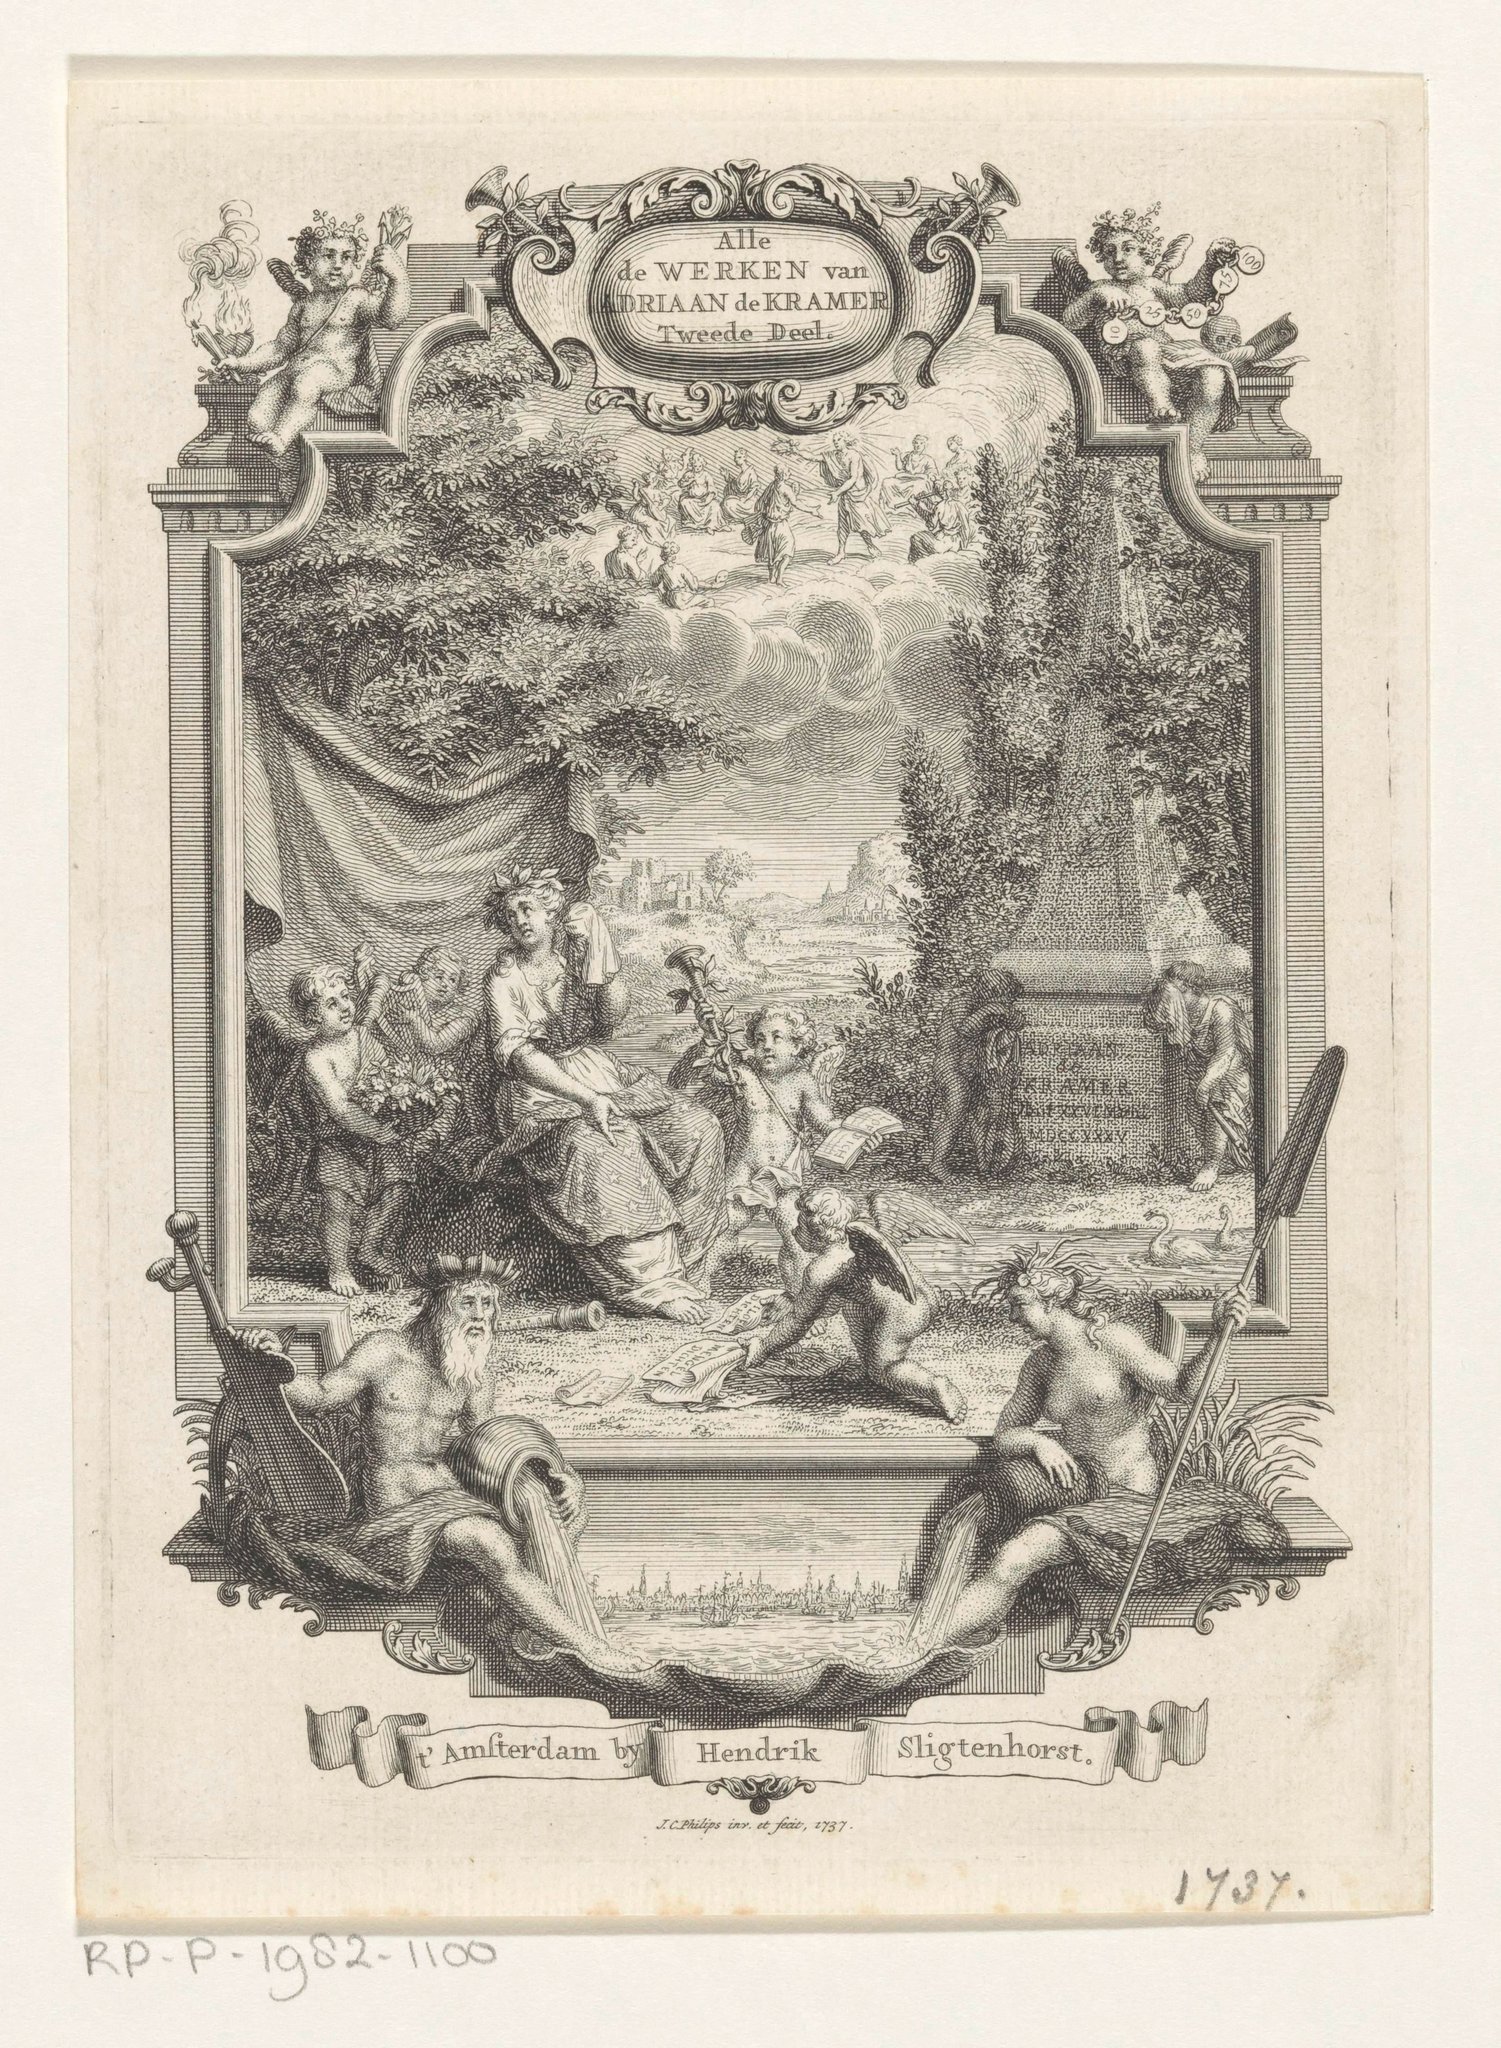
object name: titelblad, titelpagina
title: Titelpagina voor: Adriaan de Kramer, Alle de werken, Tweede Deel, 1737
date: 1737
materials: paper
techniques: engraving, etching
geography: amsterdam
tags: amsterdam, symbolic representations, allegories and emblems ~ poetry; 'poesia' (ripa), crowning with laurel, grave, tomb and other grave-forms and grave-markers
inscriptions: collector's mark: Lugt, collector's mark: Lugt 2760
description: Poëzie treurt om de dood van de schrijver Adriaan de Kramer. Ze wordt vergezeld door putti met attributen die de kunsten symboliseren. Op de achtergrond het grafmonument met het portret van de schrijver. In de hemel wordt hij gelauwerd, omringd door muzen. In de omlijsting van de cartouche een gezicht op Amsterdam, geflankeerd door twee riviergoden. Op de bovenhoeken putti met Vanitas symbolen.